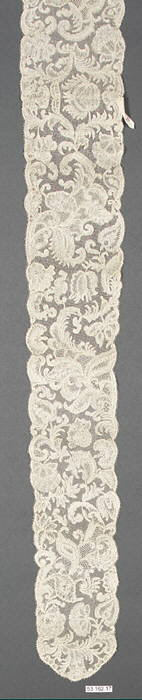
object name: lappet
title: Joined pair of lappets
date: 1701-1800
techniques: lace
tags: flowers